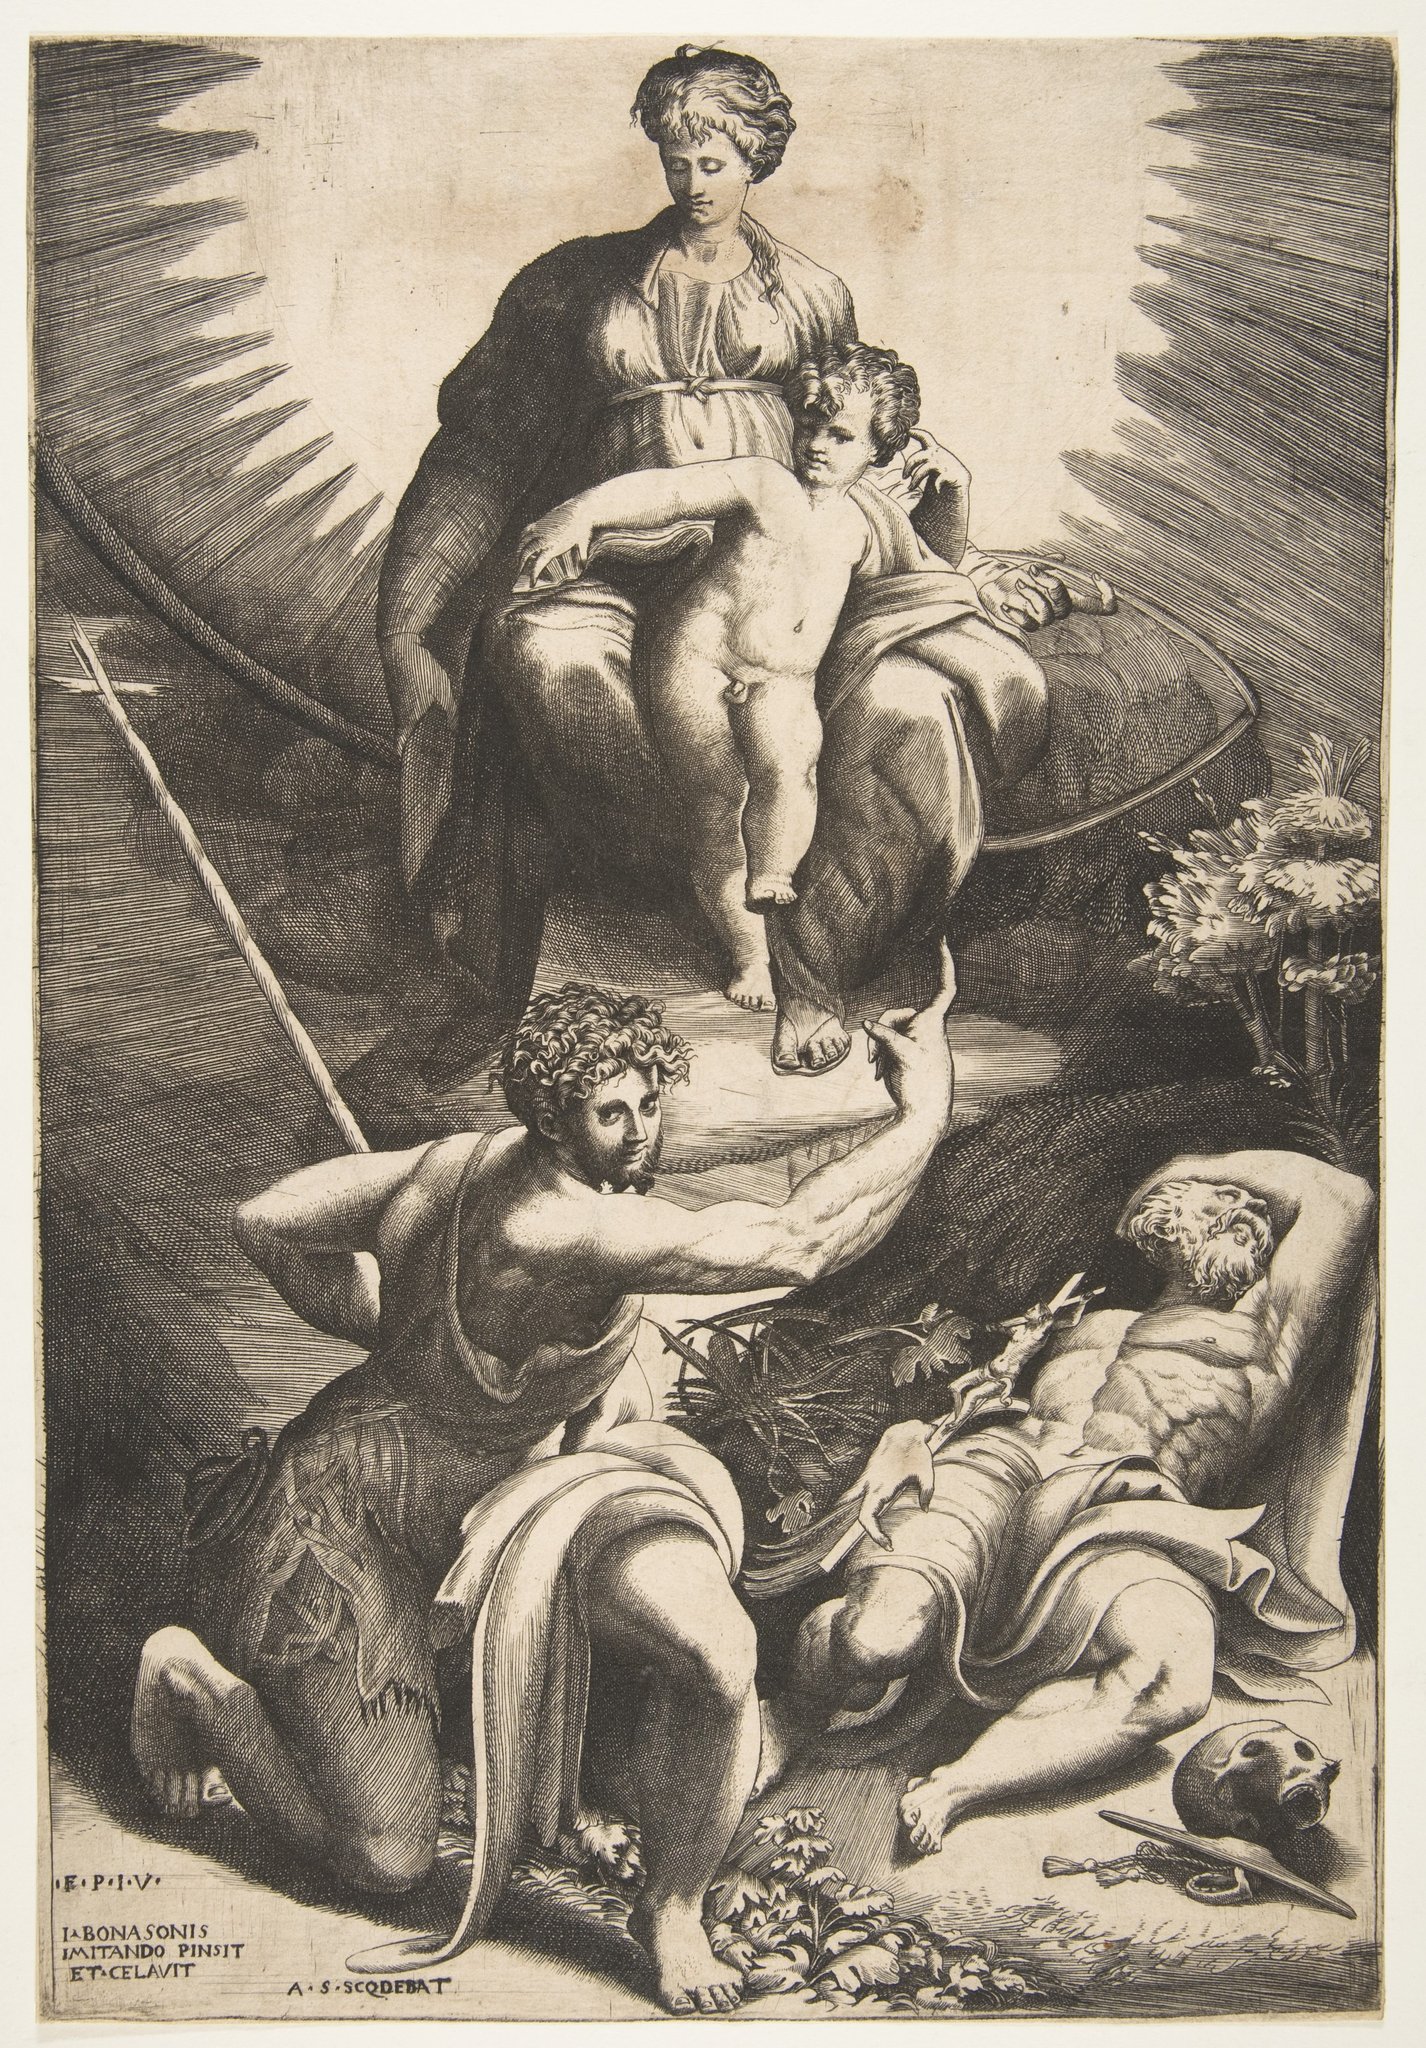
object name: print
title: The vision of Saint Jerome who is asleep in the bottom right, the Virgin and Child appear above being pointed to by Saint John the Baptist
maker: giulio bonasone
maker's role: artist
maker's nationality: italian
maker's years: 1510-1576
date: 1531-1576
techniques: engraving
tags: sleeping,saint jerome,saint john the baptist,virgin mary,jesus